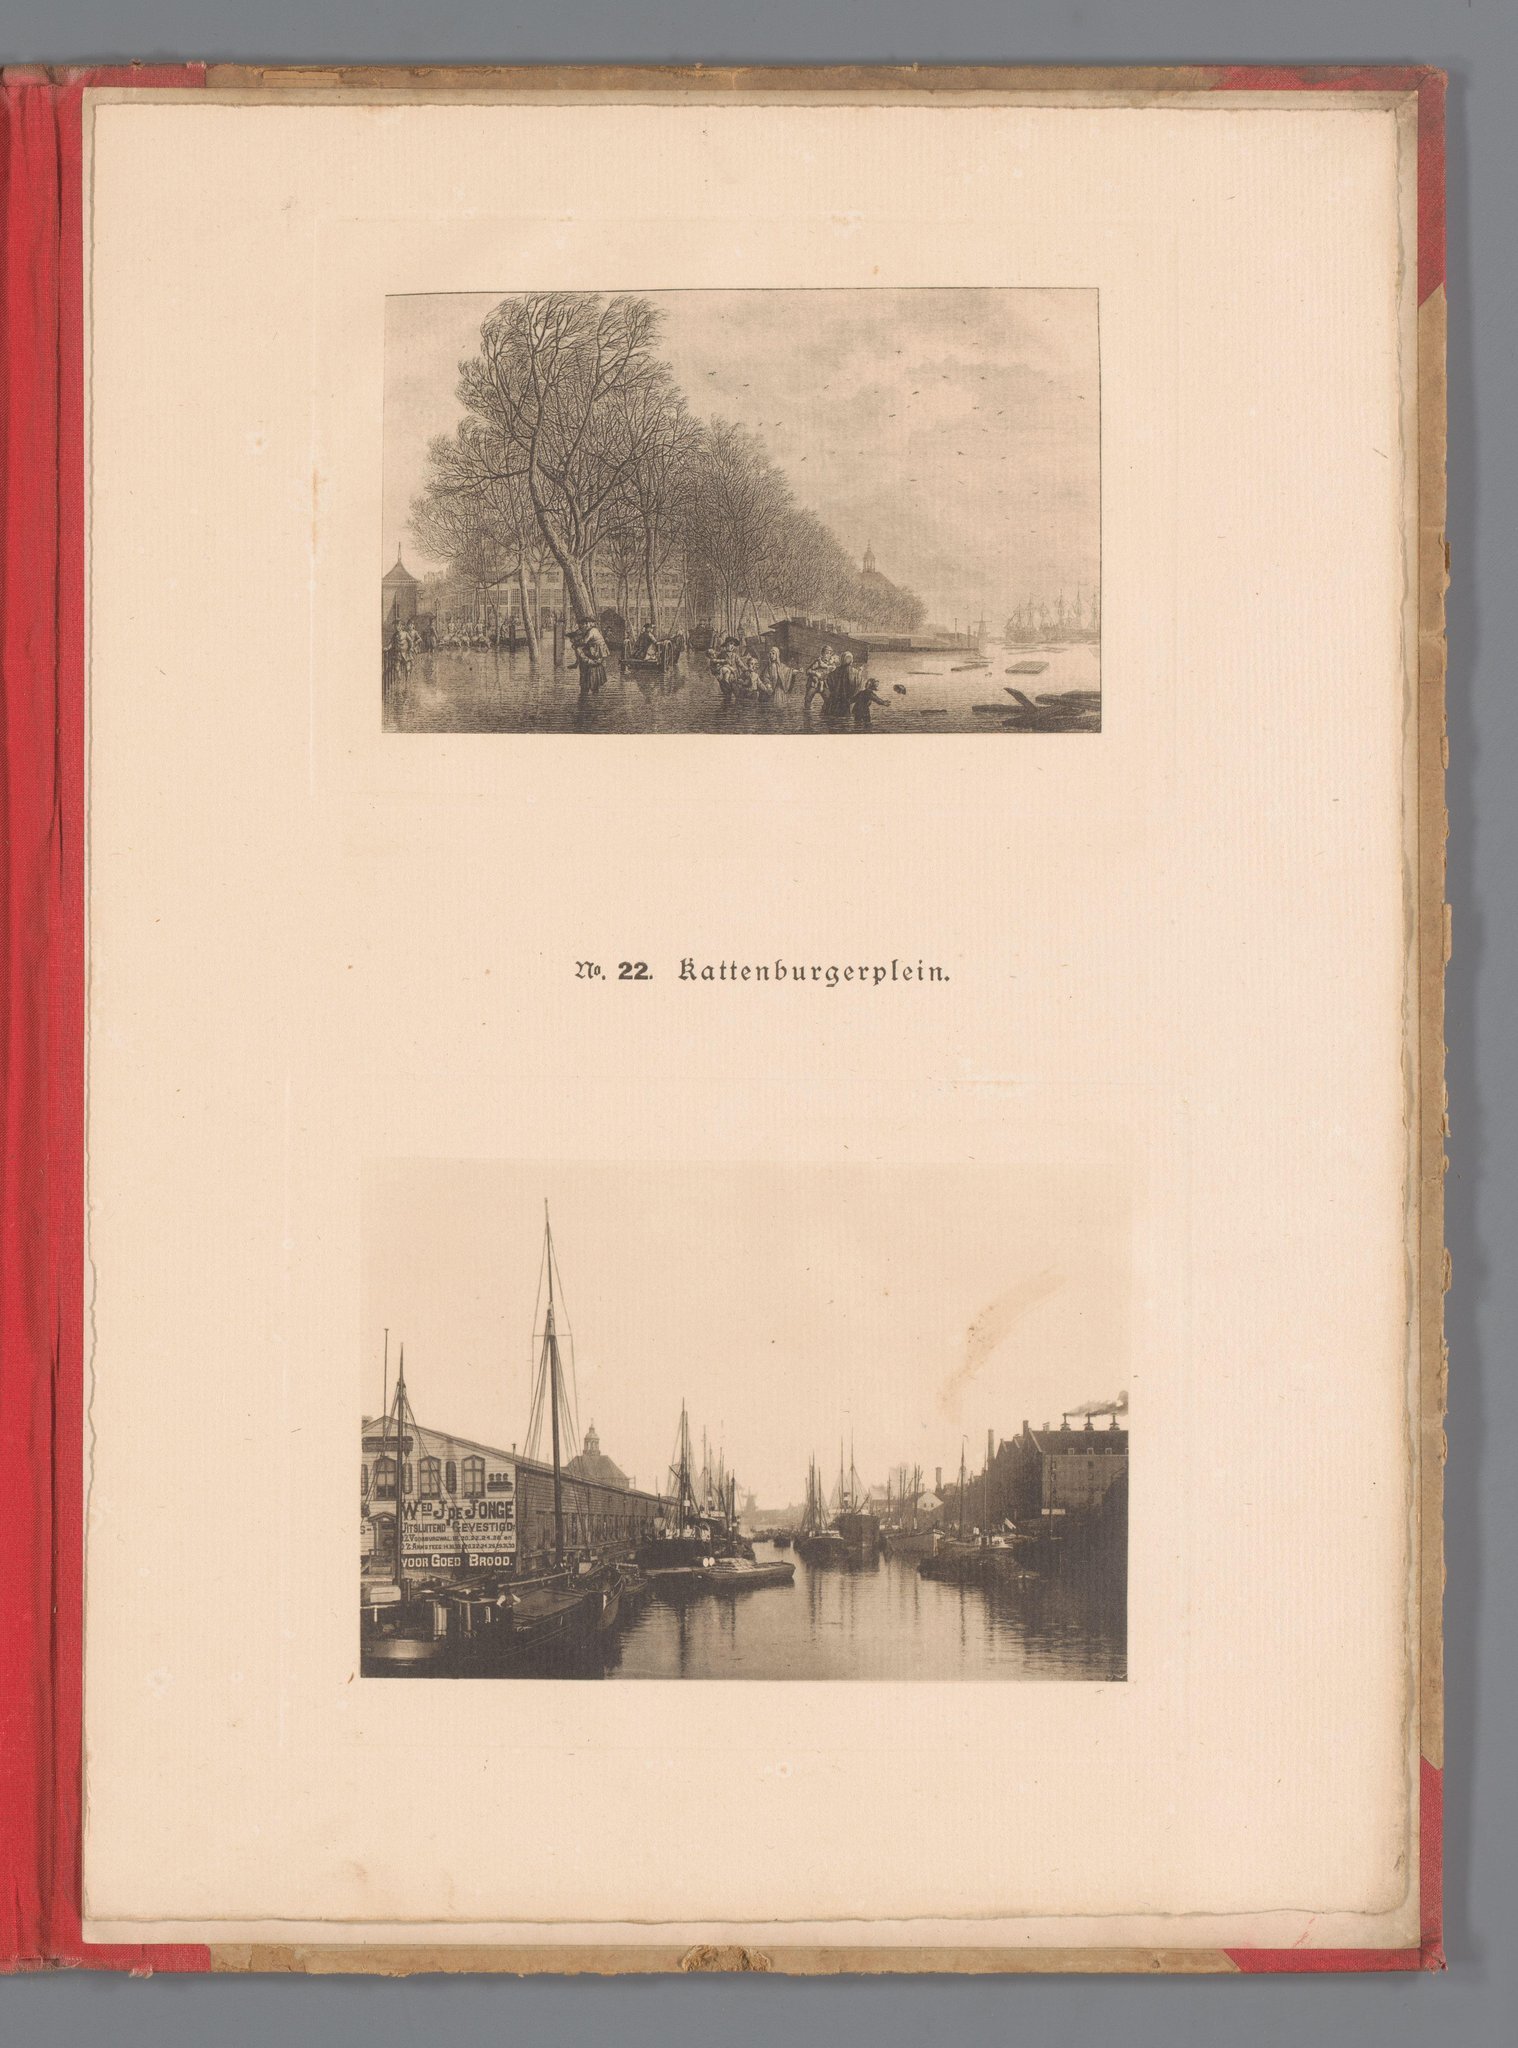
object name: reproduction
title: Twee gezichten op het Kattenburgerplein te Amsterdam, waarvan één reproductie van een prent met de watersnood in 1775 door Noach van der Meer II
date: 1890-1900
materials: paper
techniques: photograph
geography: amsterdam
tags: dike-break, road, path, canals, waters (in city) (+ city(-scape) with figures, staffage), the flood of 14-18 november 1775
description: Deze prenten maken deel uit van een album.